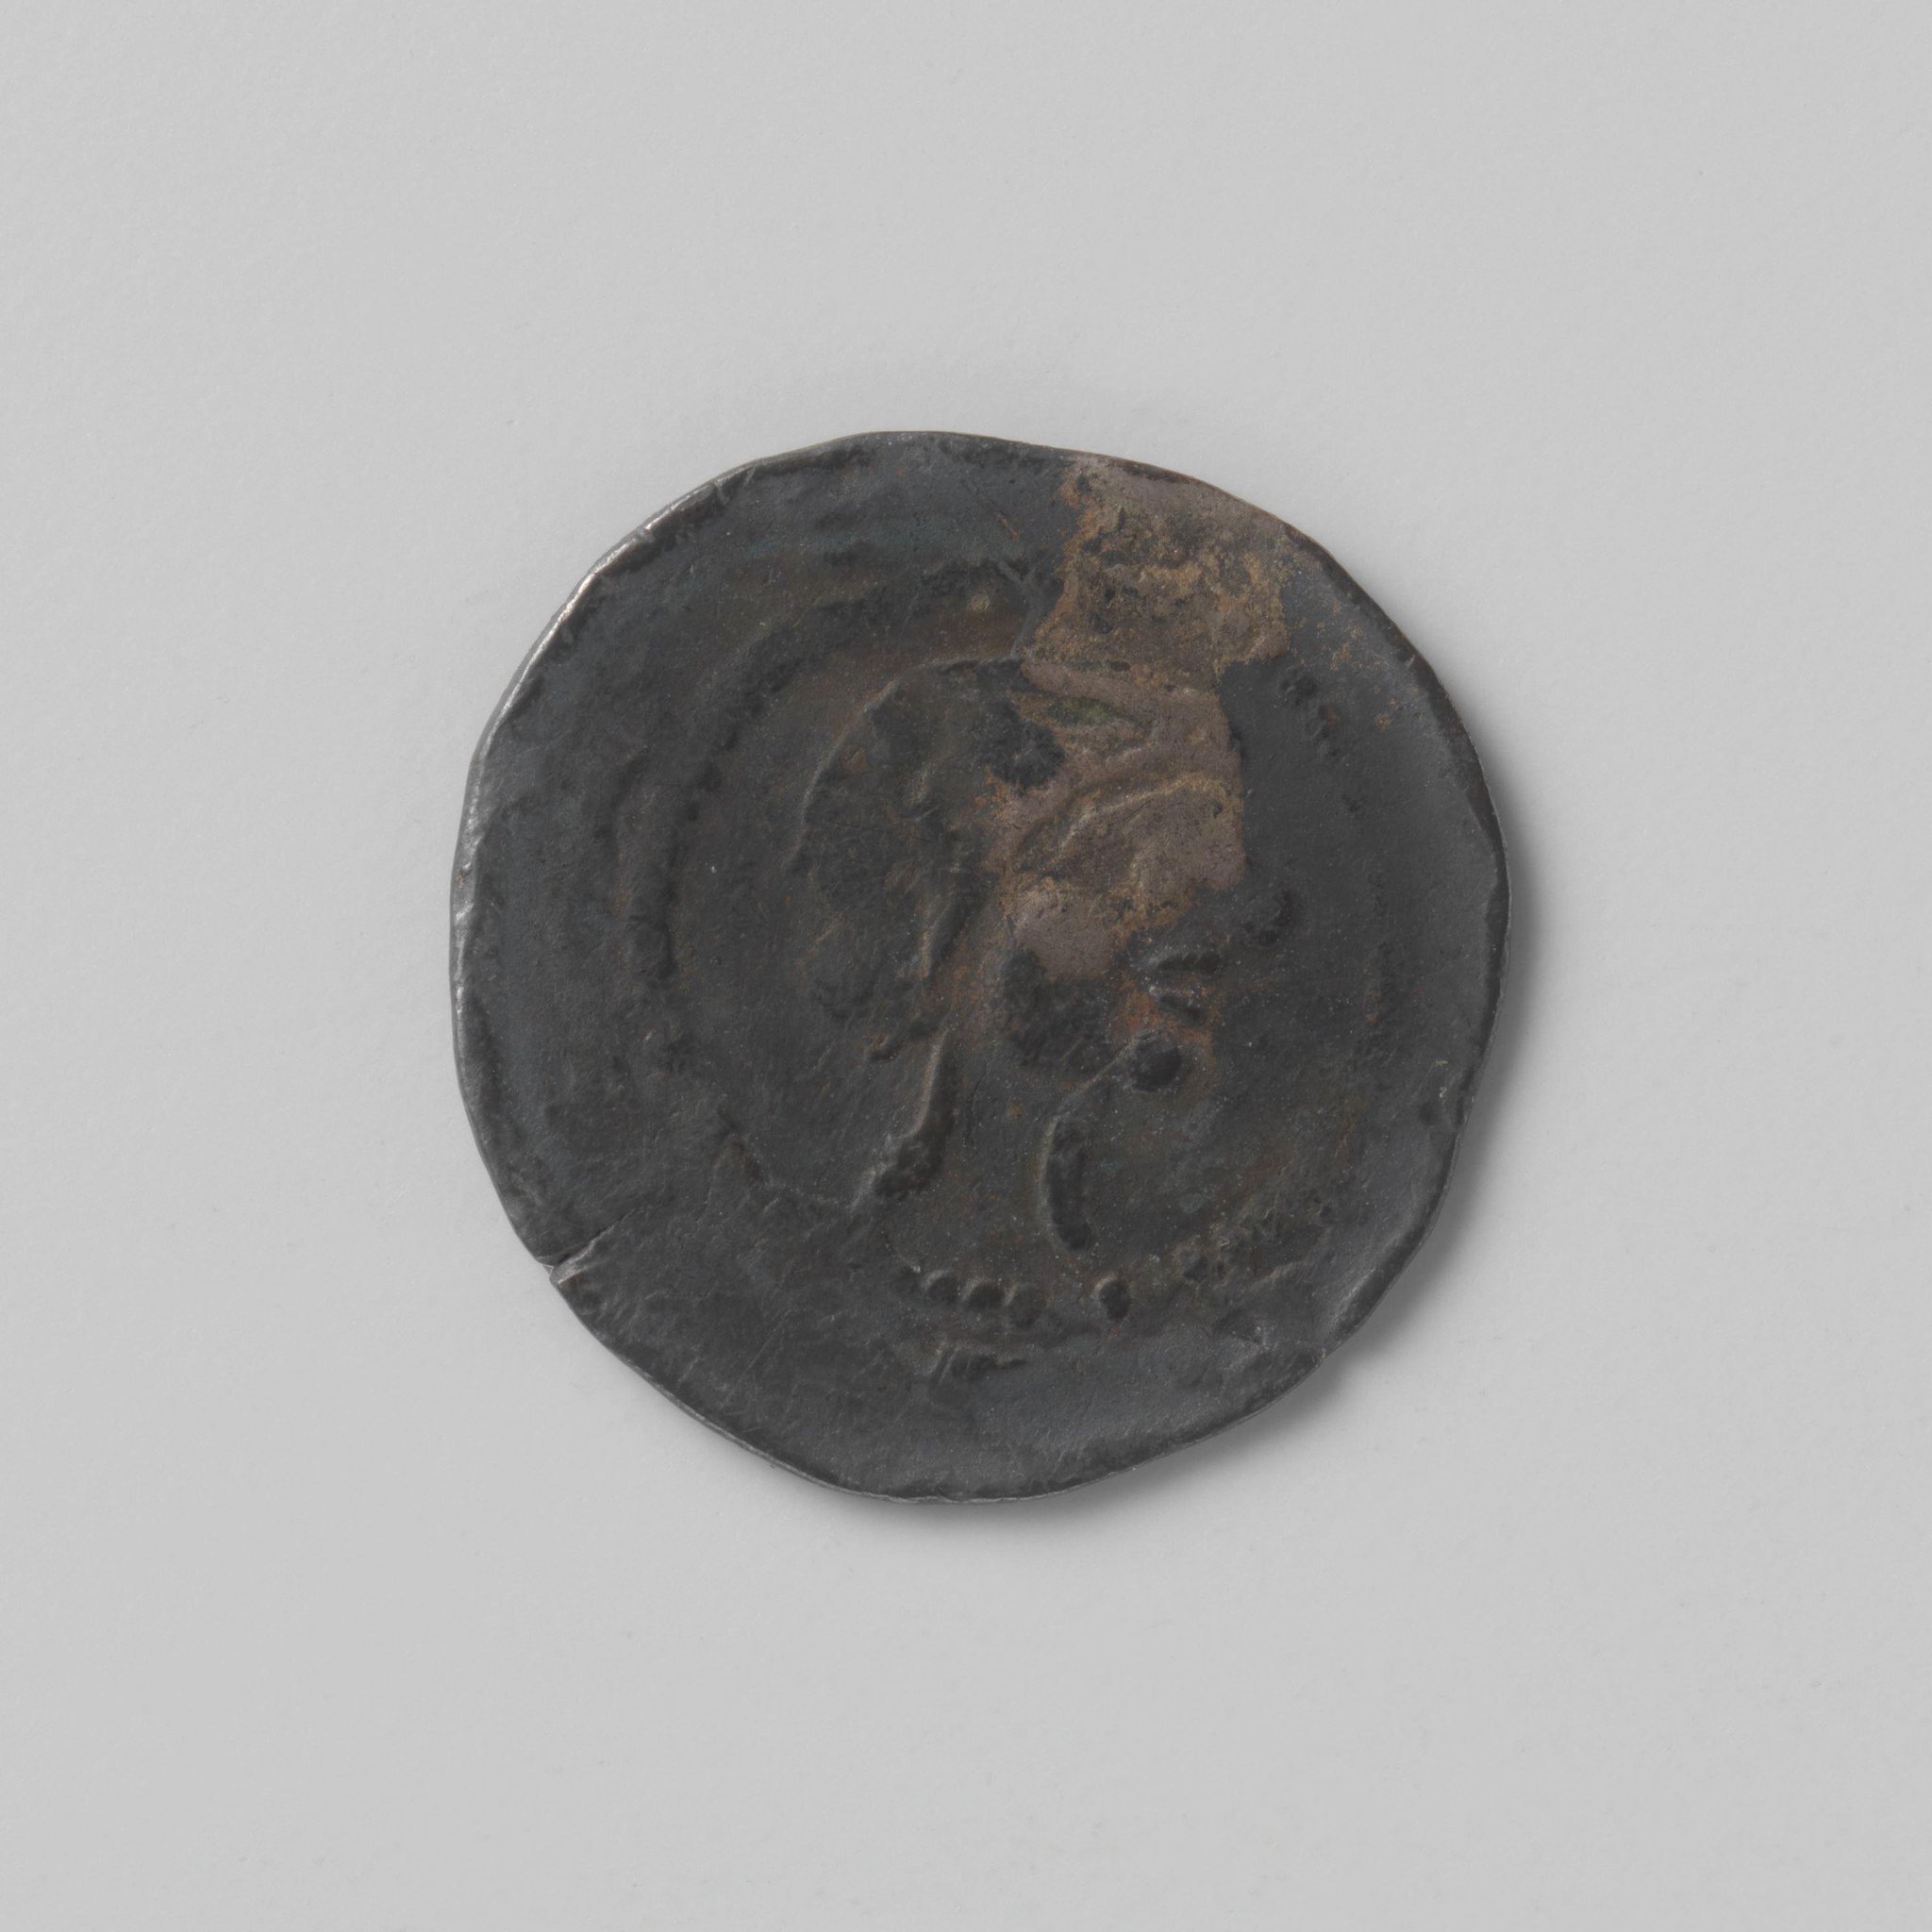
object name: coin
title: Hollandse penning van Floris V, 1256-1296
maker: floris v (graaf van holland en zeeland)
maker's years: 1254-1296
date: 1256-1258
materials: silver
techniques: striking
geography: dordrecht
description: Zilveren munt. Voorzijde: hoofd met gravenmuts naar rechts. Keerzijde: lang dubellijnig kruis.